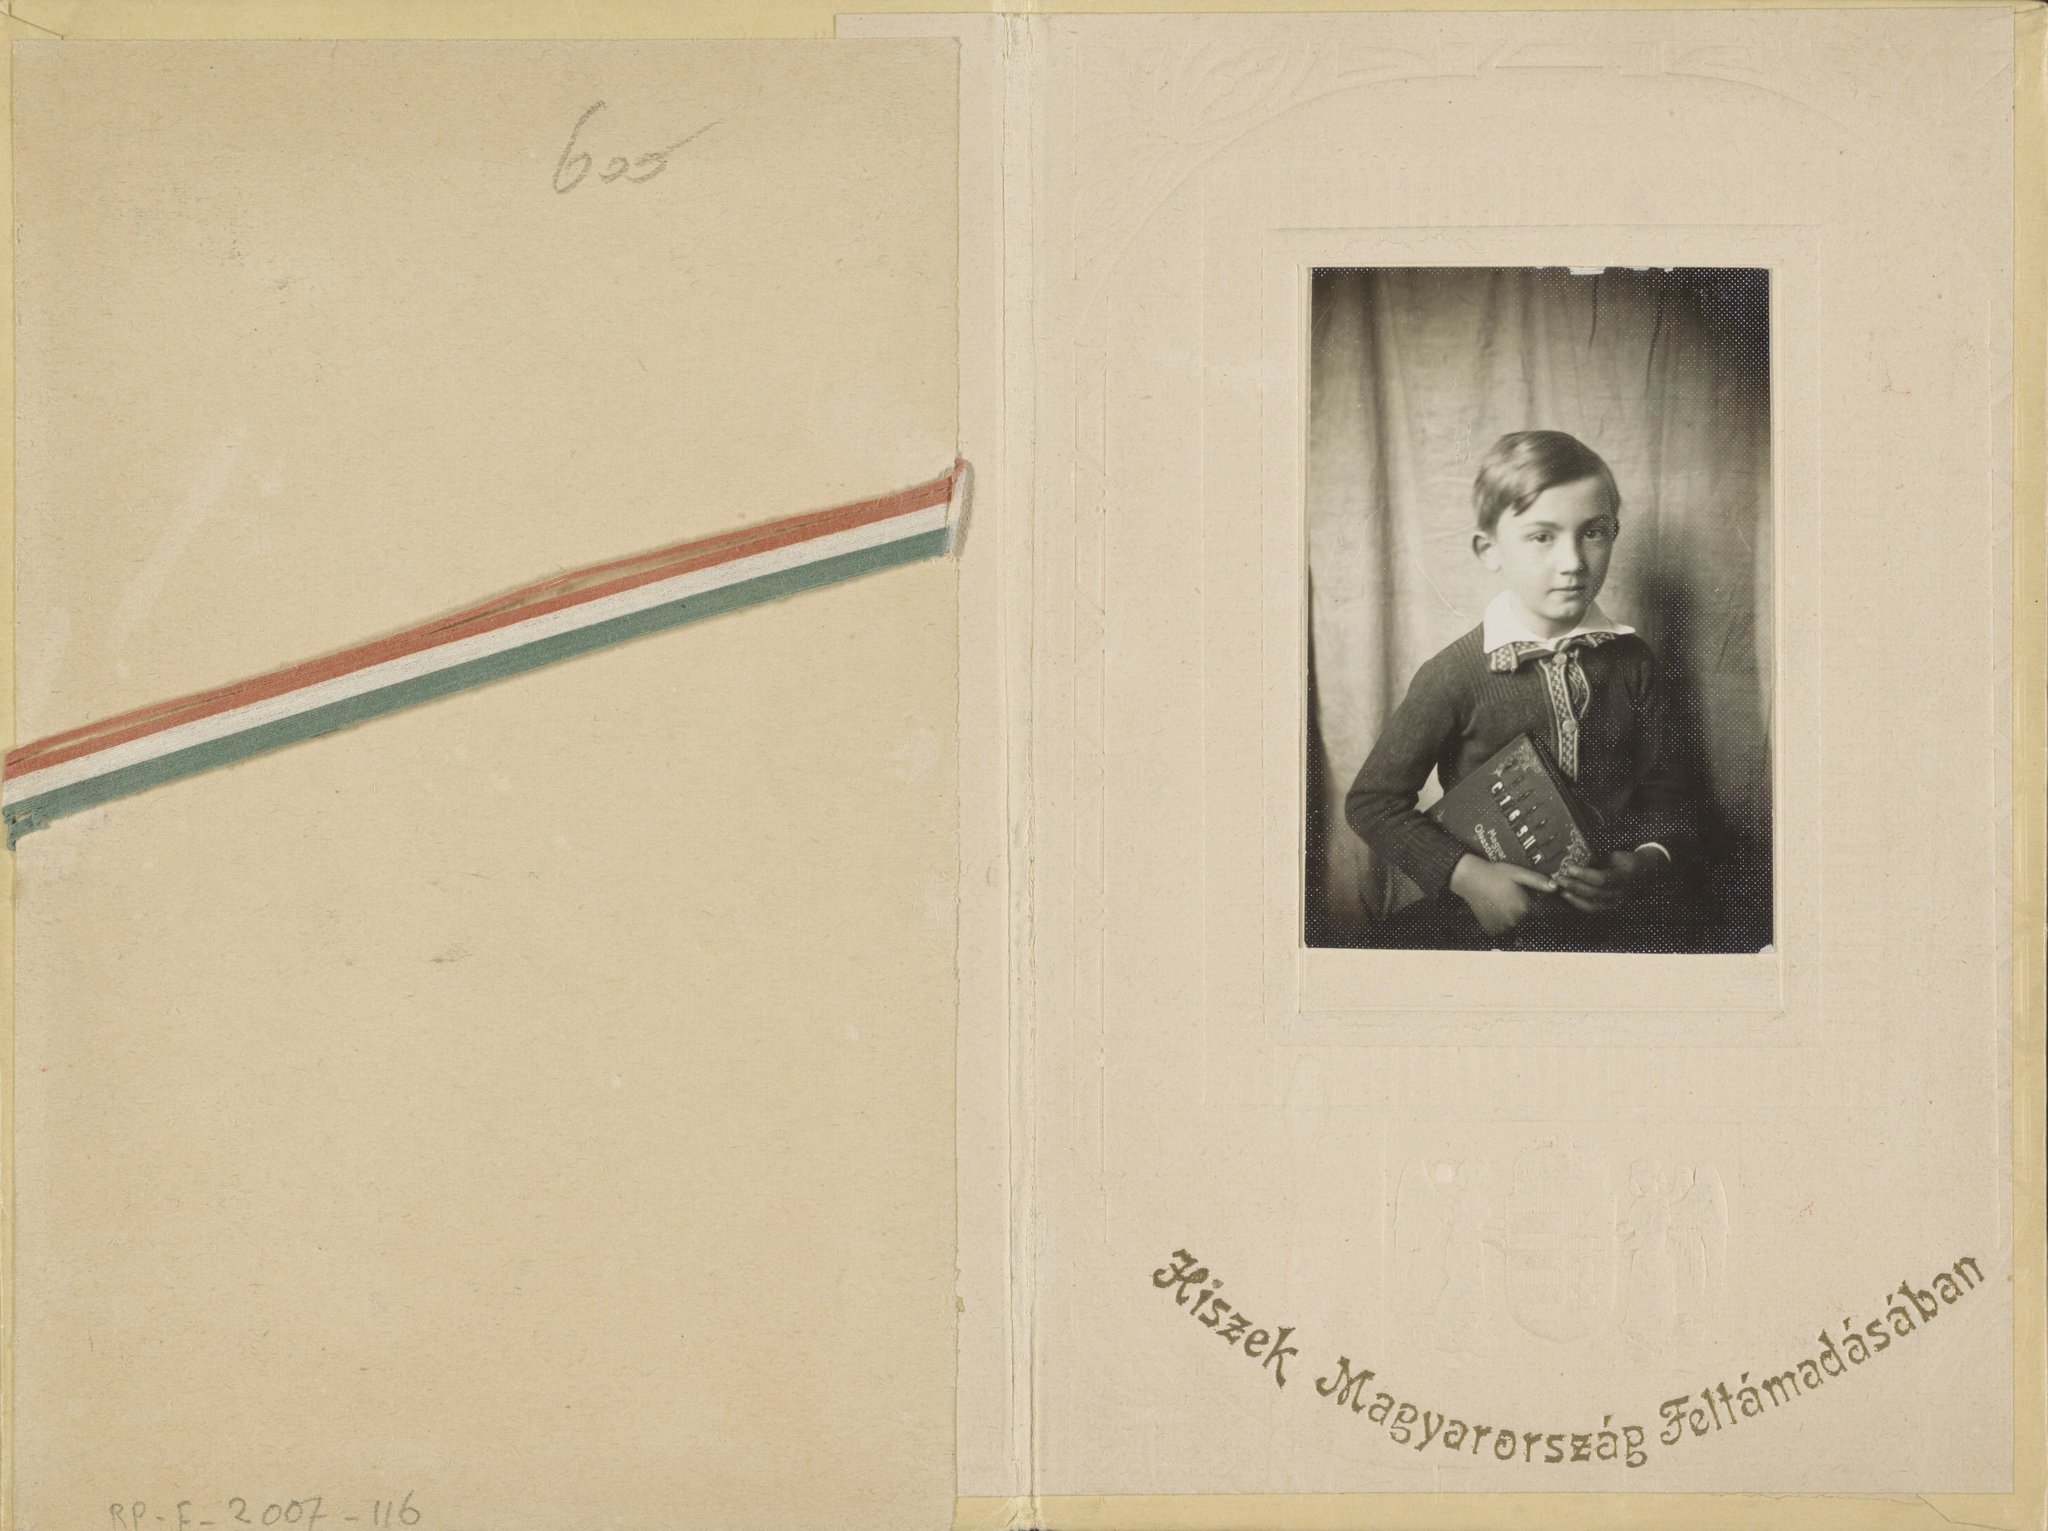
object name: photograph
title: Portret van een jongen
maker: Anonymous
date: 1915-1920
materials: cardboard, photographic support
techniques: gelatin silver print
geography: hungary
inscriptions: caption: ‘Hiszek Magyarország Feltámadásában’, inscription: ‘Édes Anyámnak’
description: Portret ten halven lijve van een jongen met een boek. Opgeplakt in kartonnen omslag met blinddruk en gedrukte tekst in het Hongaars, en rood-wit-groen lint.